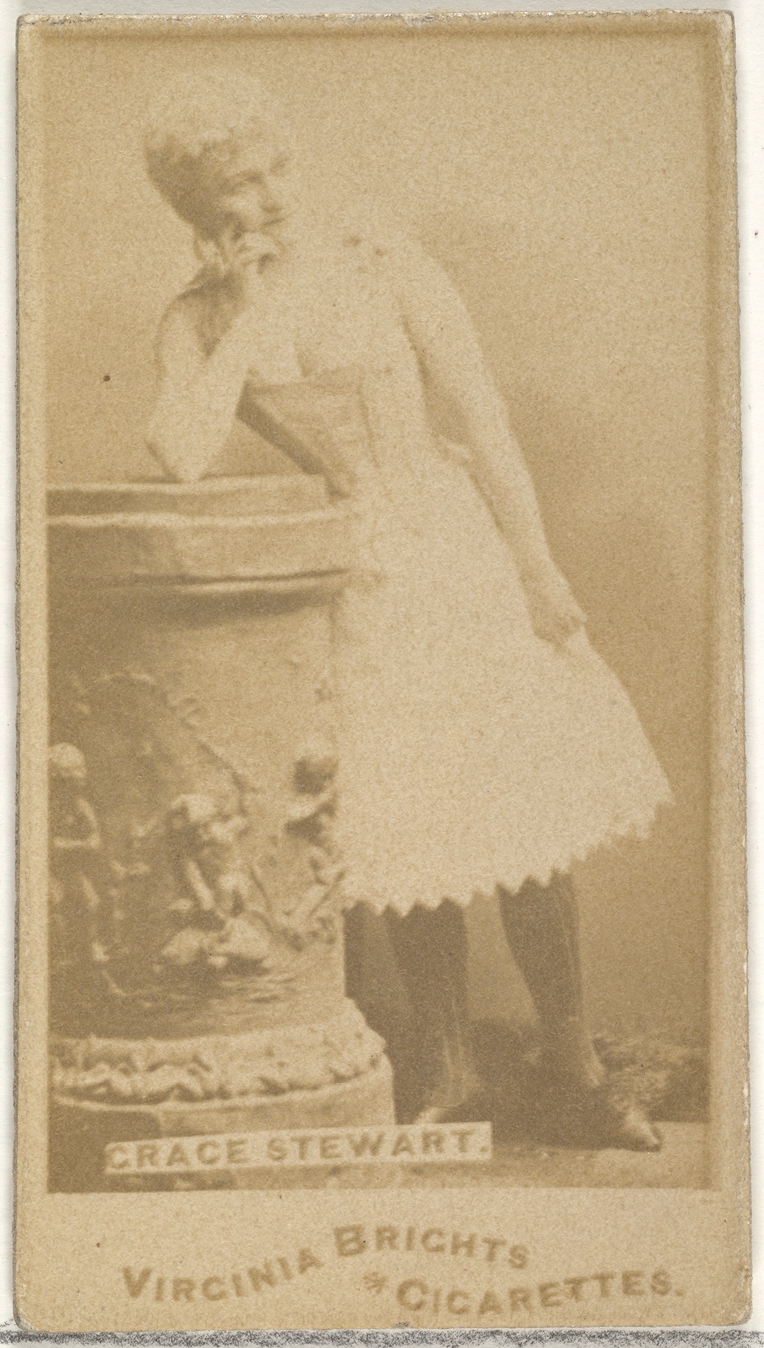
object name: photograph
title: Grace Stewart, from the Actors and Actresses series (N45, Type 1) for Virginia Brights Cigarettes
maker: allen & ginter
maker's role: publisher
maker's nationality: american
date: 1888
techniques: albumen silver print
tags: portraits,women,actresses